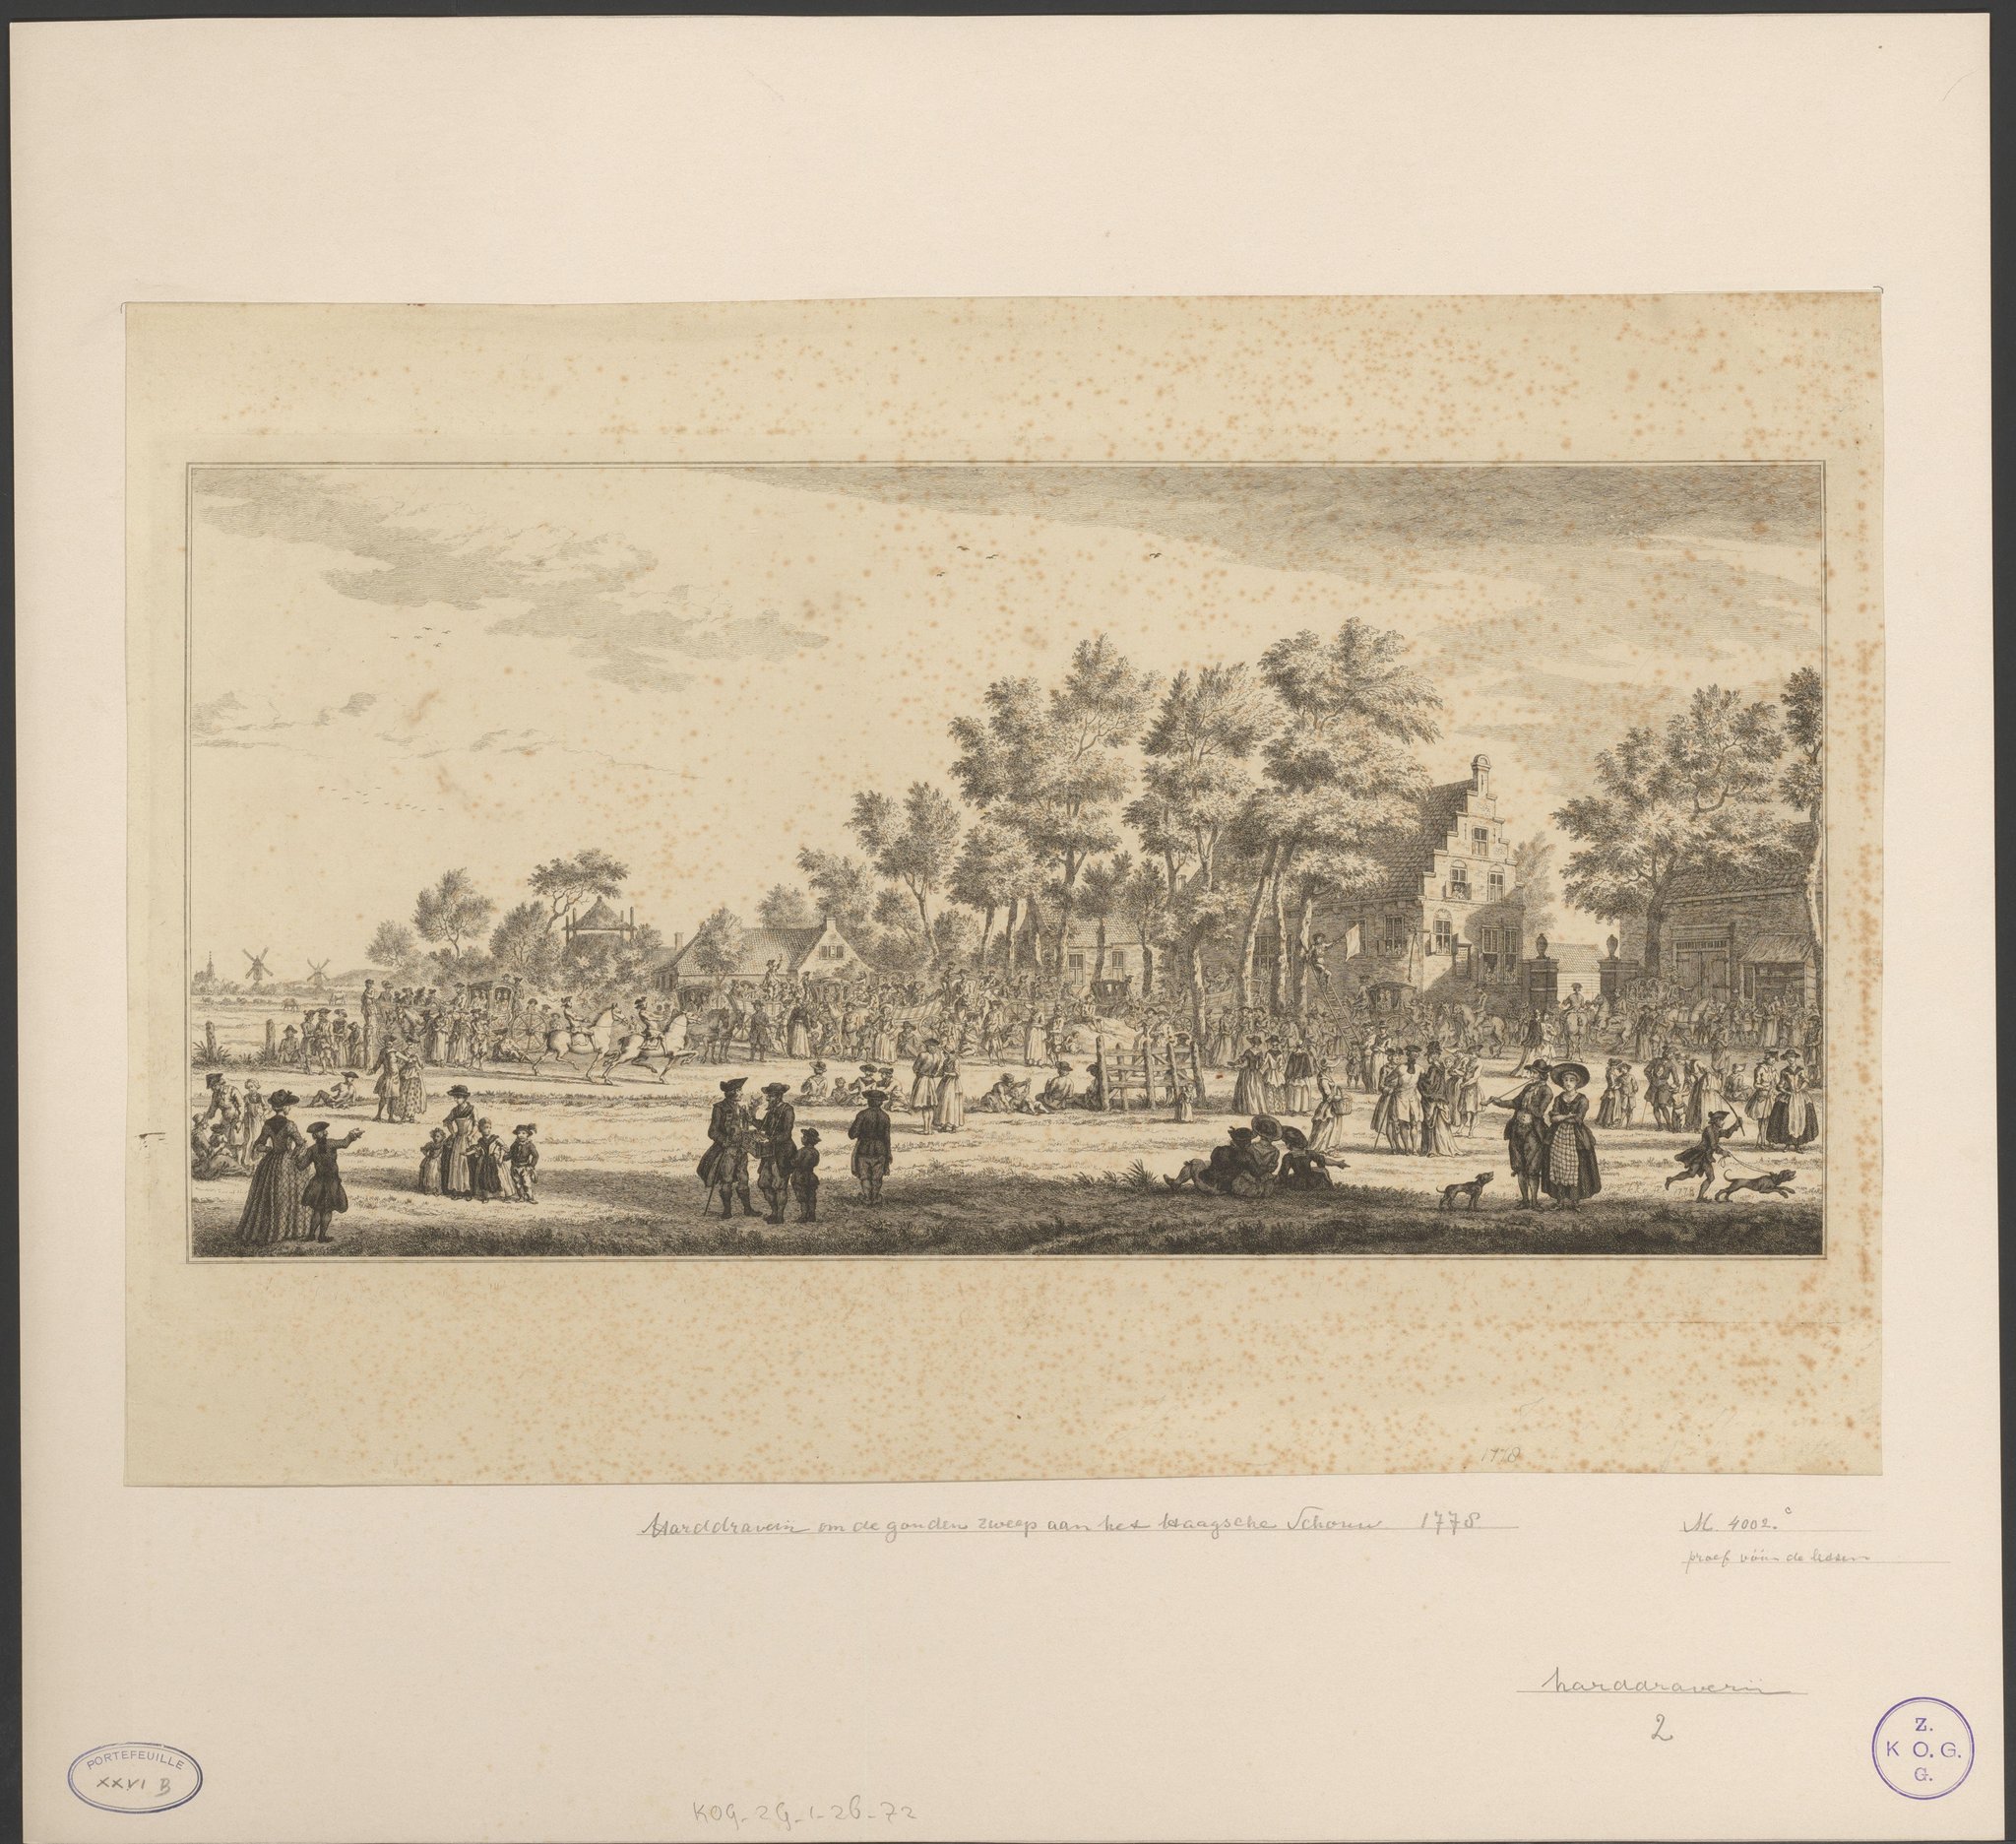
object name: print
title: Harddraverij om de Gouden Zweep, aan het Haagsche Schouw, 1778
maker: simon fokke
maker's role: draughtsman, print maker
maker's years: 1712-1784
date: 1778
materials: paper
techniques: etching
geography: northern netherlands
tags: horse-racing, the hague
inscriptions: collector's mark: Lugt 1641, collector's mark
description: De Hollandse harddraverij om de gouden zweep aan het Haagsche Schouw, 1778. Paardenraces op een vlakte buiten de stad Den Haag, met veel publiek zittend op de grond of in wagens en rijtuigen. Druk zonder het onderschrift. Onderwerpsrubrieken binnen de Atlas Zeden en Gewoonten: Spel en Vermaak; Harddraverij.